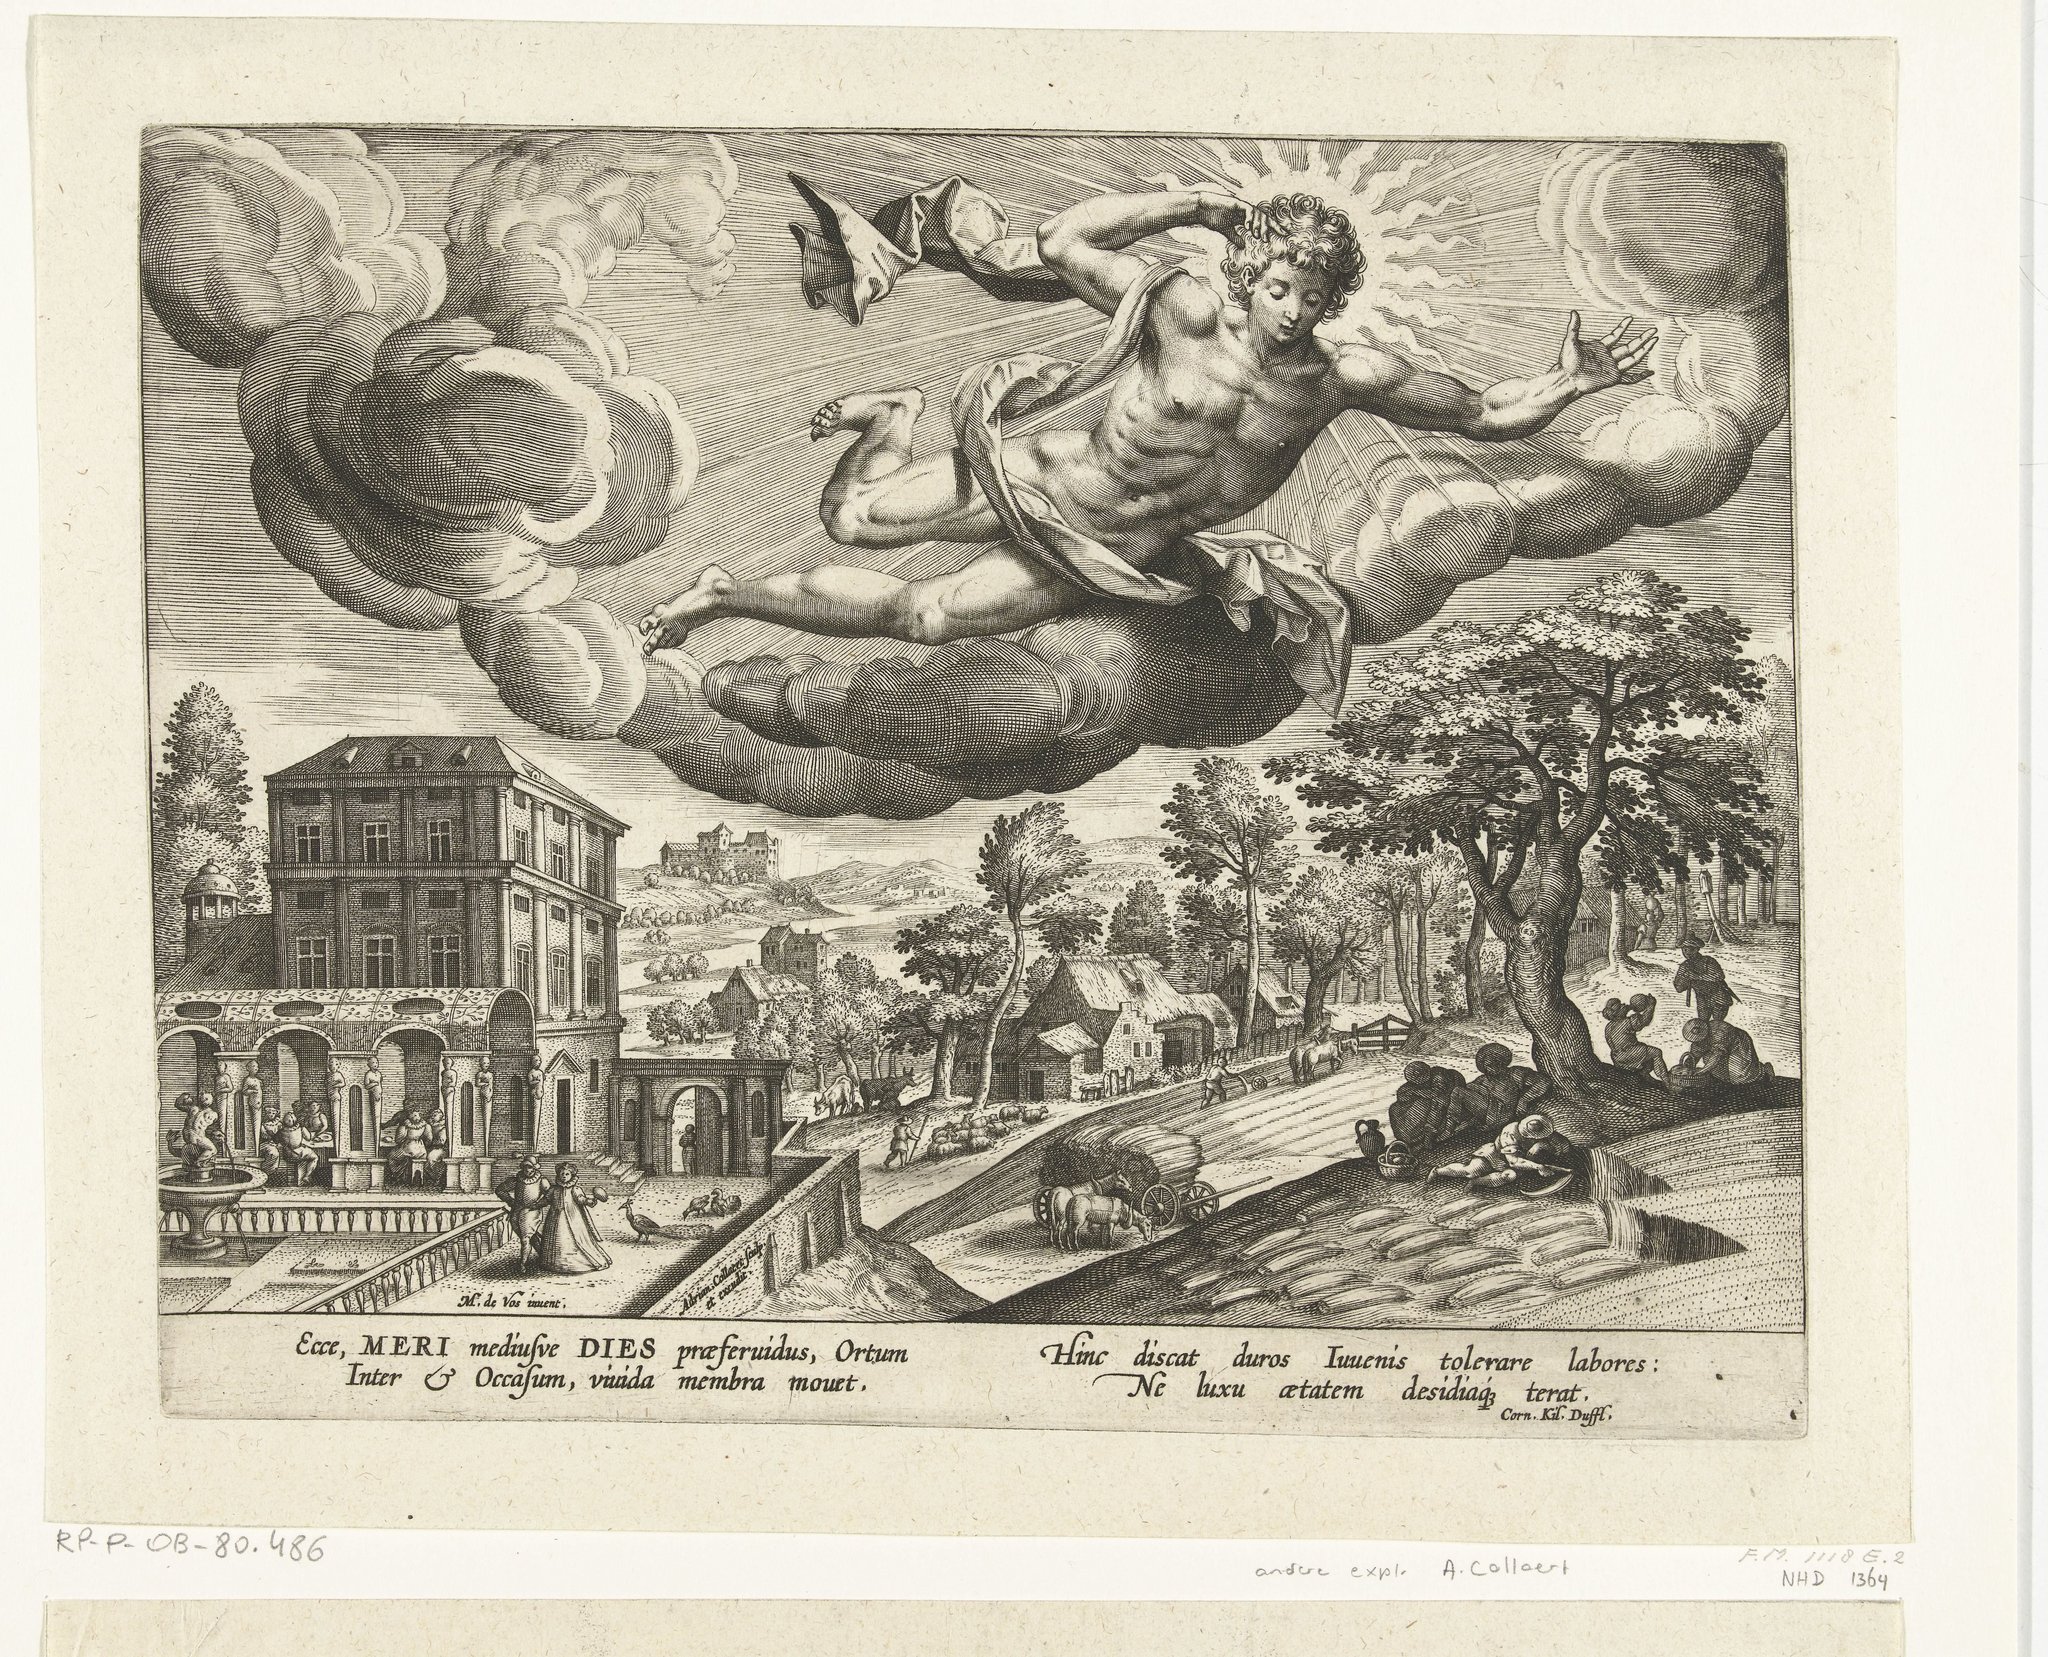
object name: print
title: Middag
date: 1590-1597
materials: paper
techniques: engraving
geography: antwerp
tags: youth, adolescent, courting, personification of the afternoon, 'meridies', low countries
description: Middag. Allegorie met in de wolken Apollo als Meridiës, de personificatie van de middag. Beneden op aarde activiteiten in relatie met de levensfase van de jeugd of jonge volwassenheid: werken op het land en liefdesparen in een tuin. Onderdeel van de serie van de vier tijden van de dag. Onder de voorstelling een opschrift van 4 regels in het Latijn.